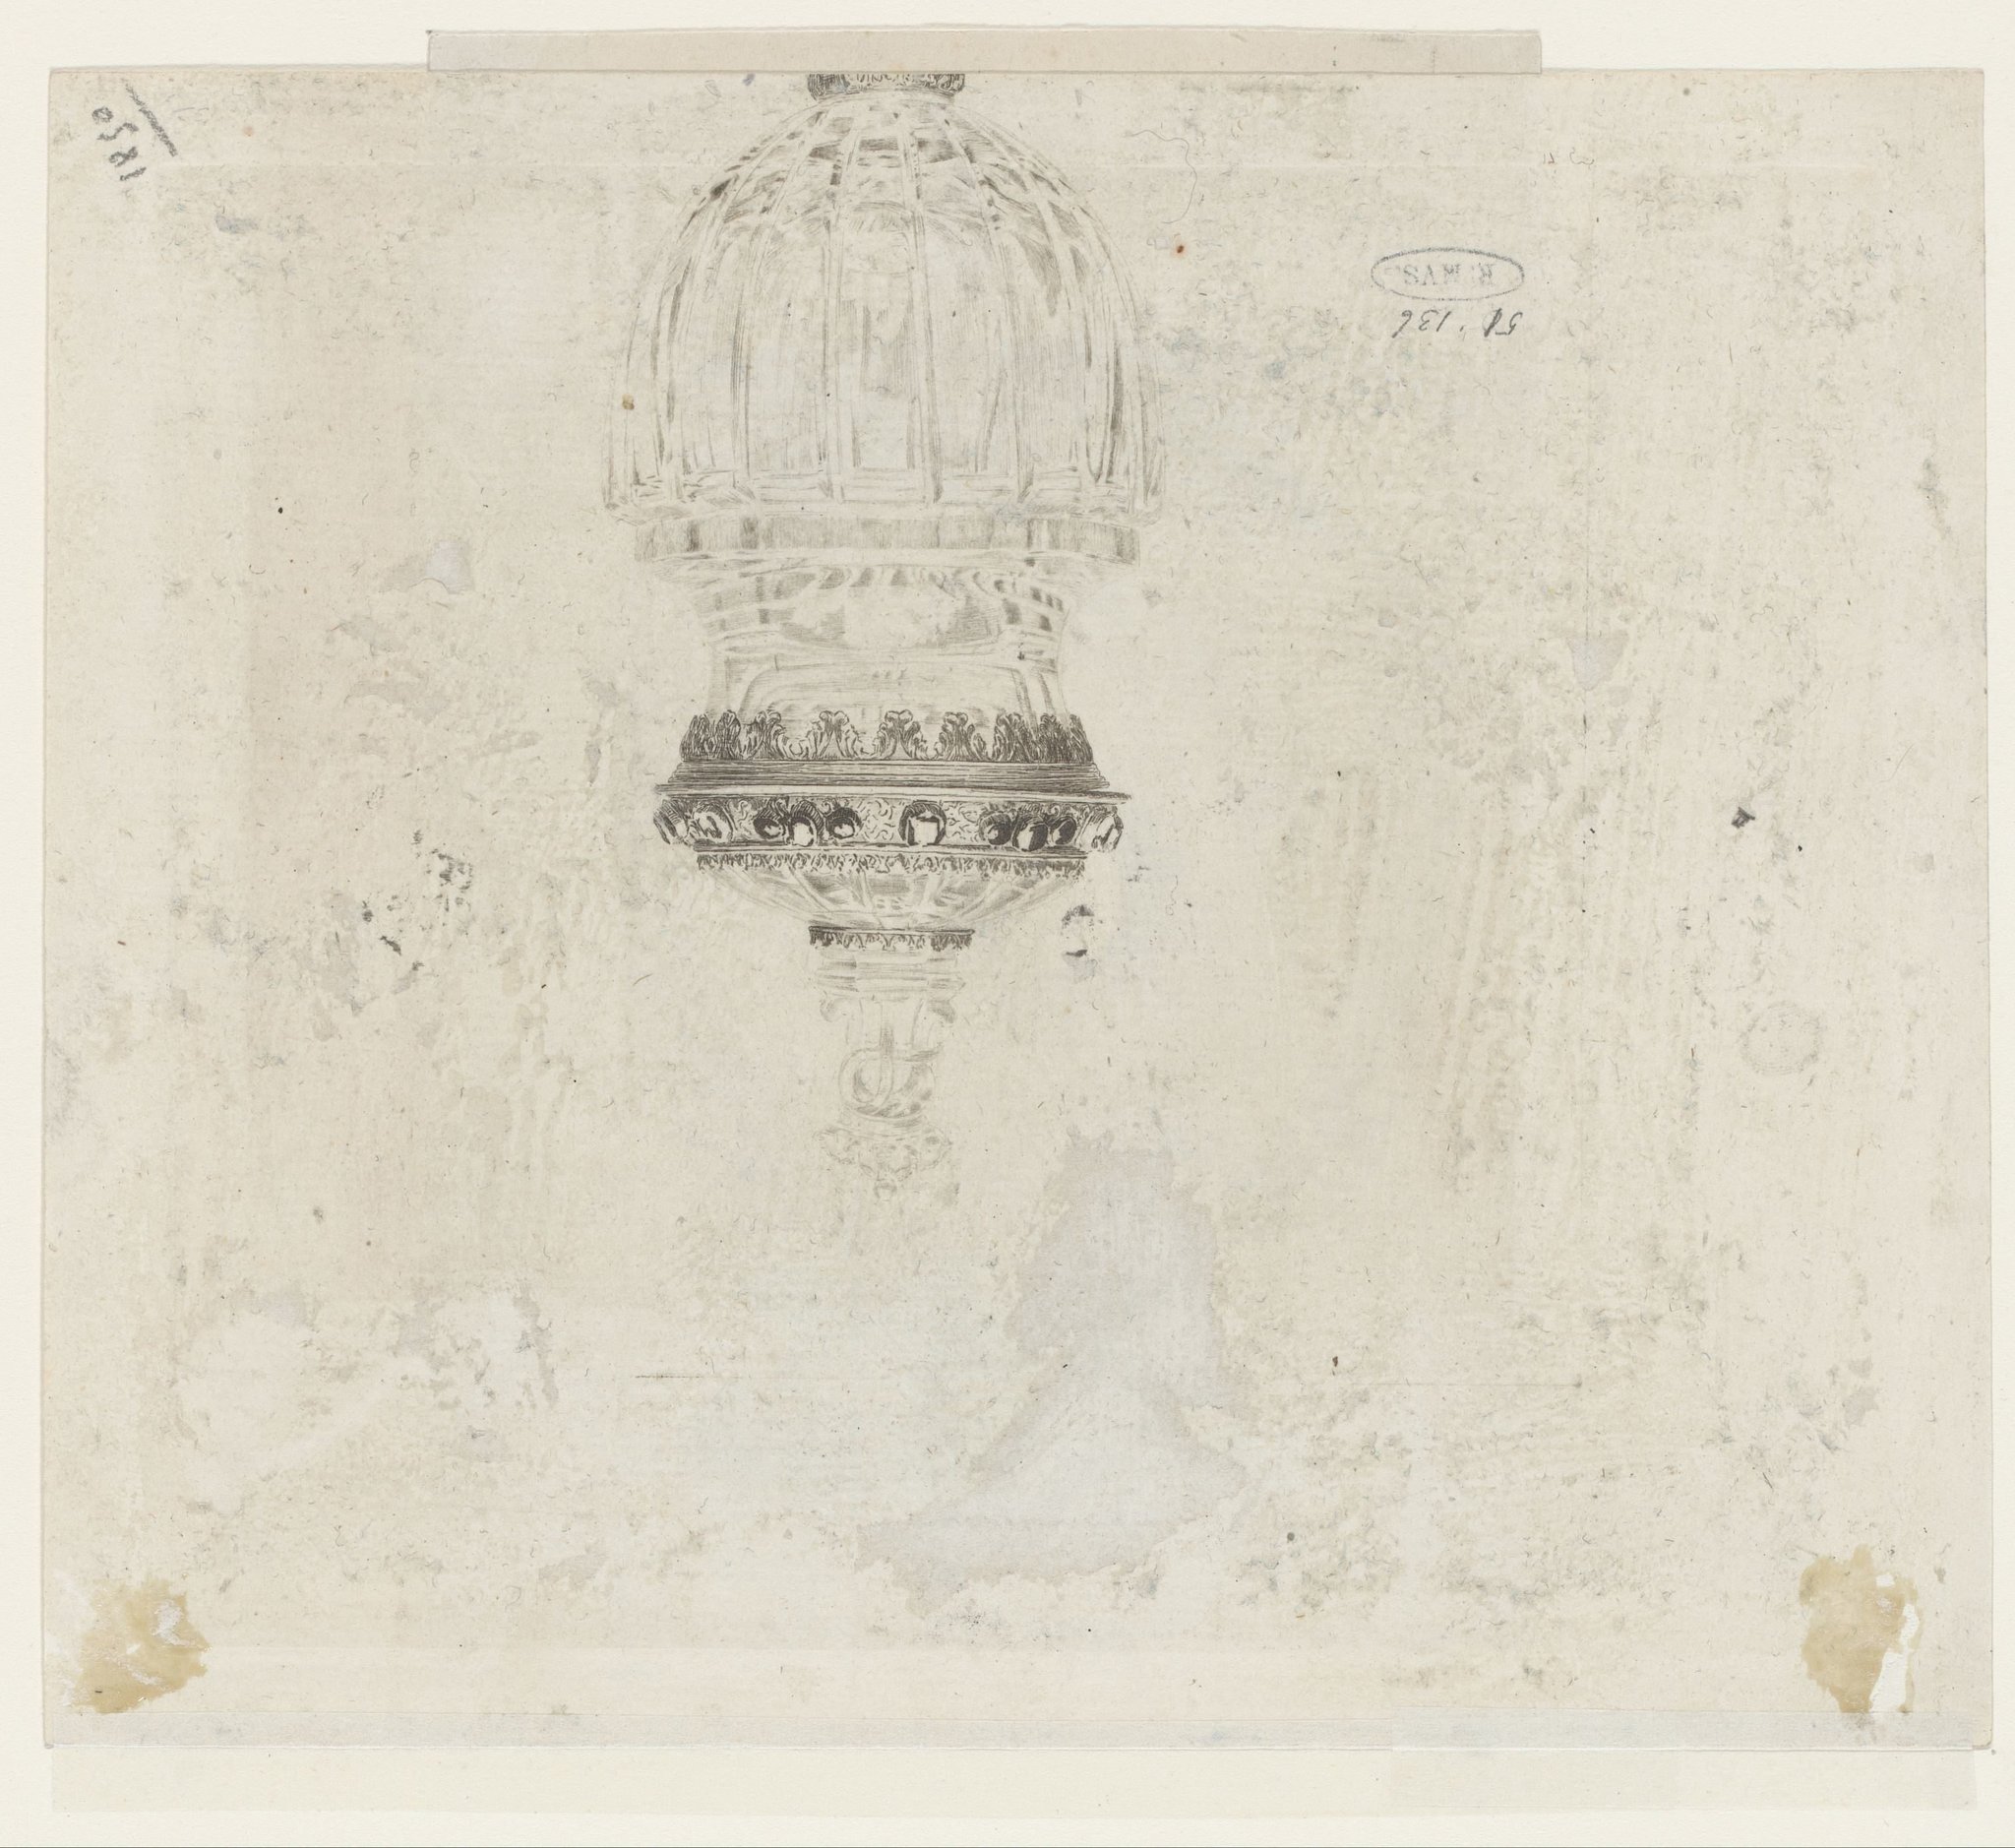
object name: print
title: Fragment van een bokaal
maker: henri charles guérard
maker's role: print maker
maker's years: 1846-1897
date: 1856-1897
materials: paper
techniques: etching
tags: container of glass: bottle, jar, vase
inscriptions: collector's mark: Lugt 2228